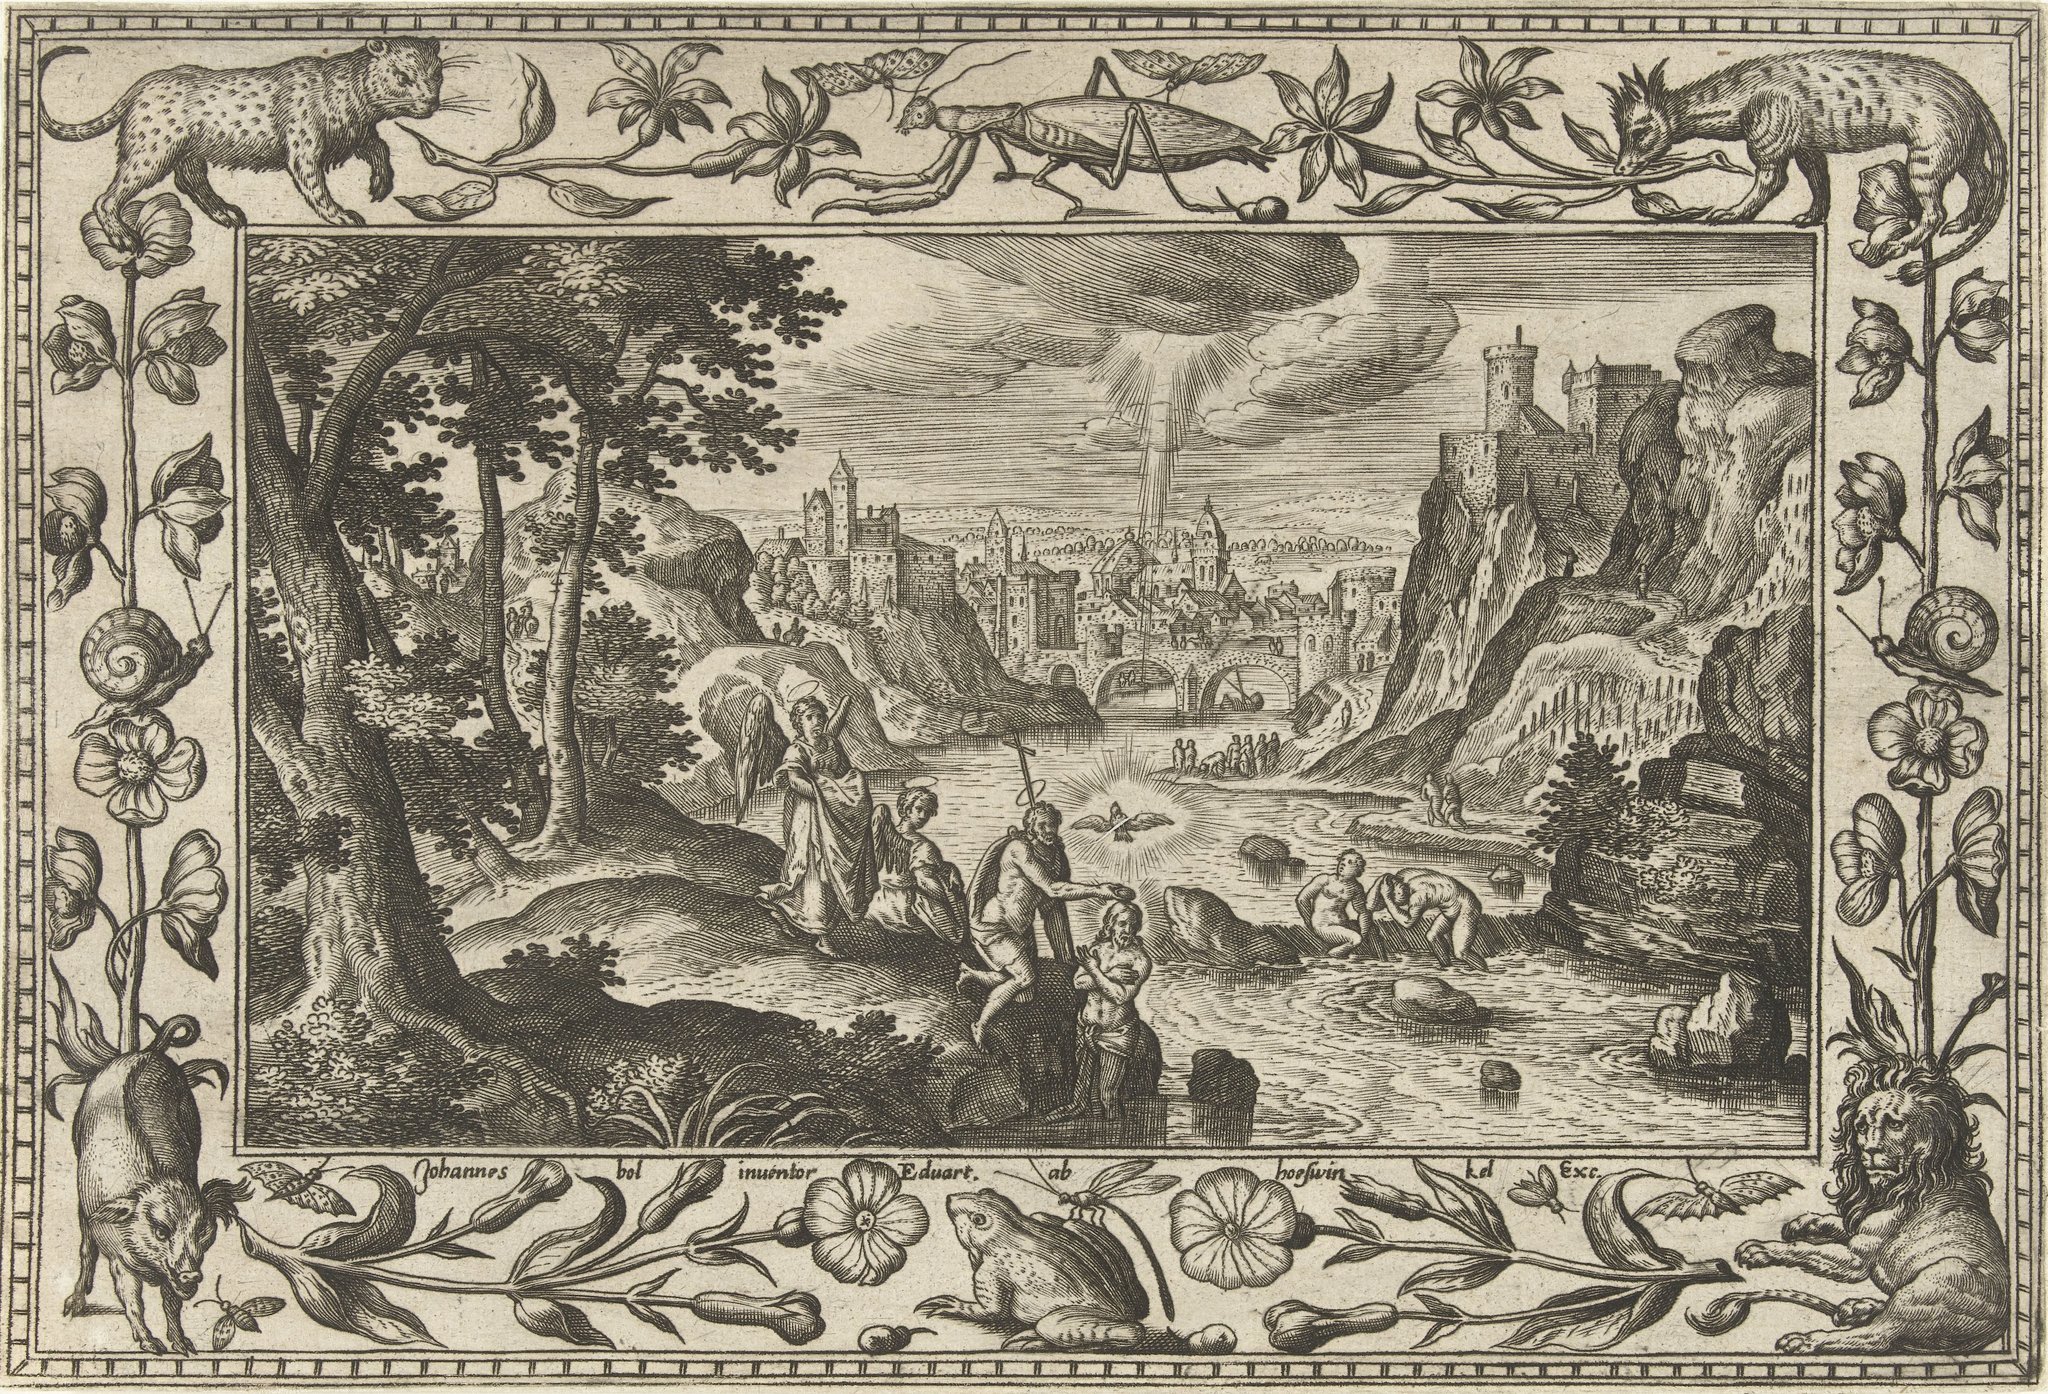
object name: print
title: Landschappen met Bijbelse, mythologische scènes en jachttaferelen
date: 1582-1586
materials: paper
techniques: engraving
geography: antwerp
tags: river, baptism of christ in the river jordan: john the baptist pouring out water on christ's head: the holy ghost descends (+ angel(s)), hoofed animals: boar (+ ornamental variants of animals), tailless amphibians: frog (+ ornamental variants of animals), beasts of prey, predatory animals: lion (+ ornamental variants of animals), cat (+ ornamental variants of animals), flowers ~ ornament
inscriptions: collector's mark: Lugt 2228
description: Rivierlandschap. Op de voorgrond wordt Christus door Johannes de Doper gedoopt in de Jordaan. Twee engelen houden zijn kleren vast. De prent heeft een ornamentlijst met bloemen en dieren. Hij maakt deel uit van een vierentwintigdelige serie van landschappen met Bijbelse, mythologische scènes en jachttaferelen.